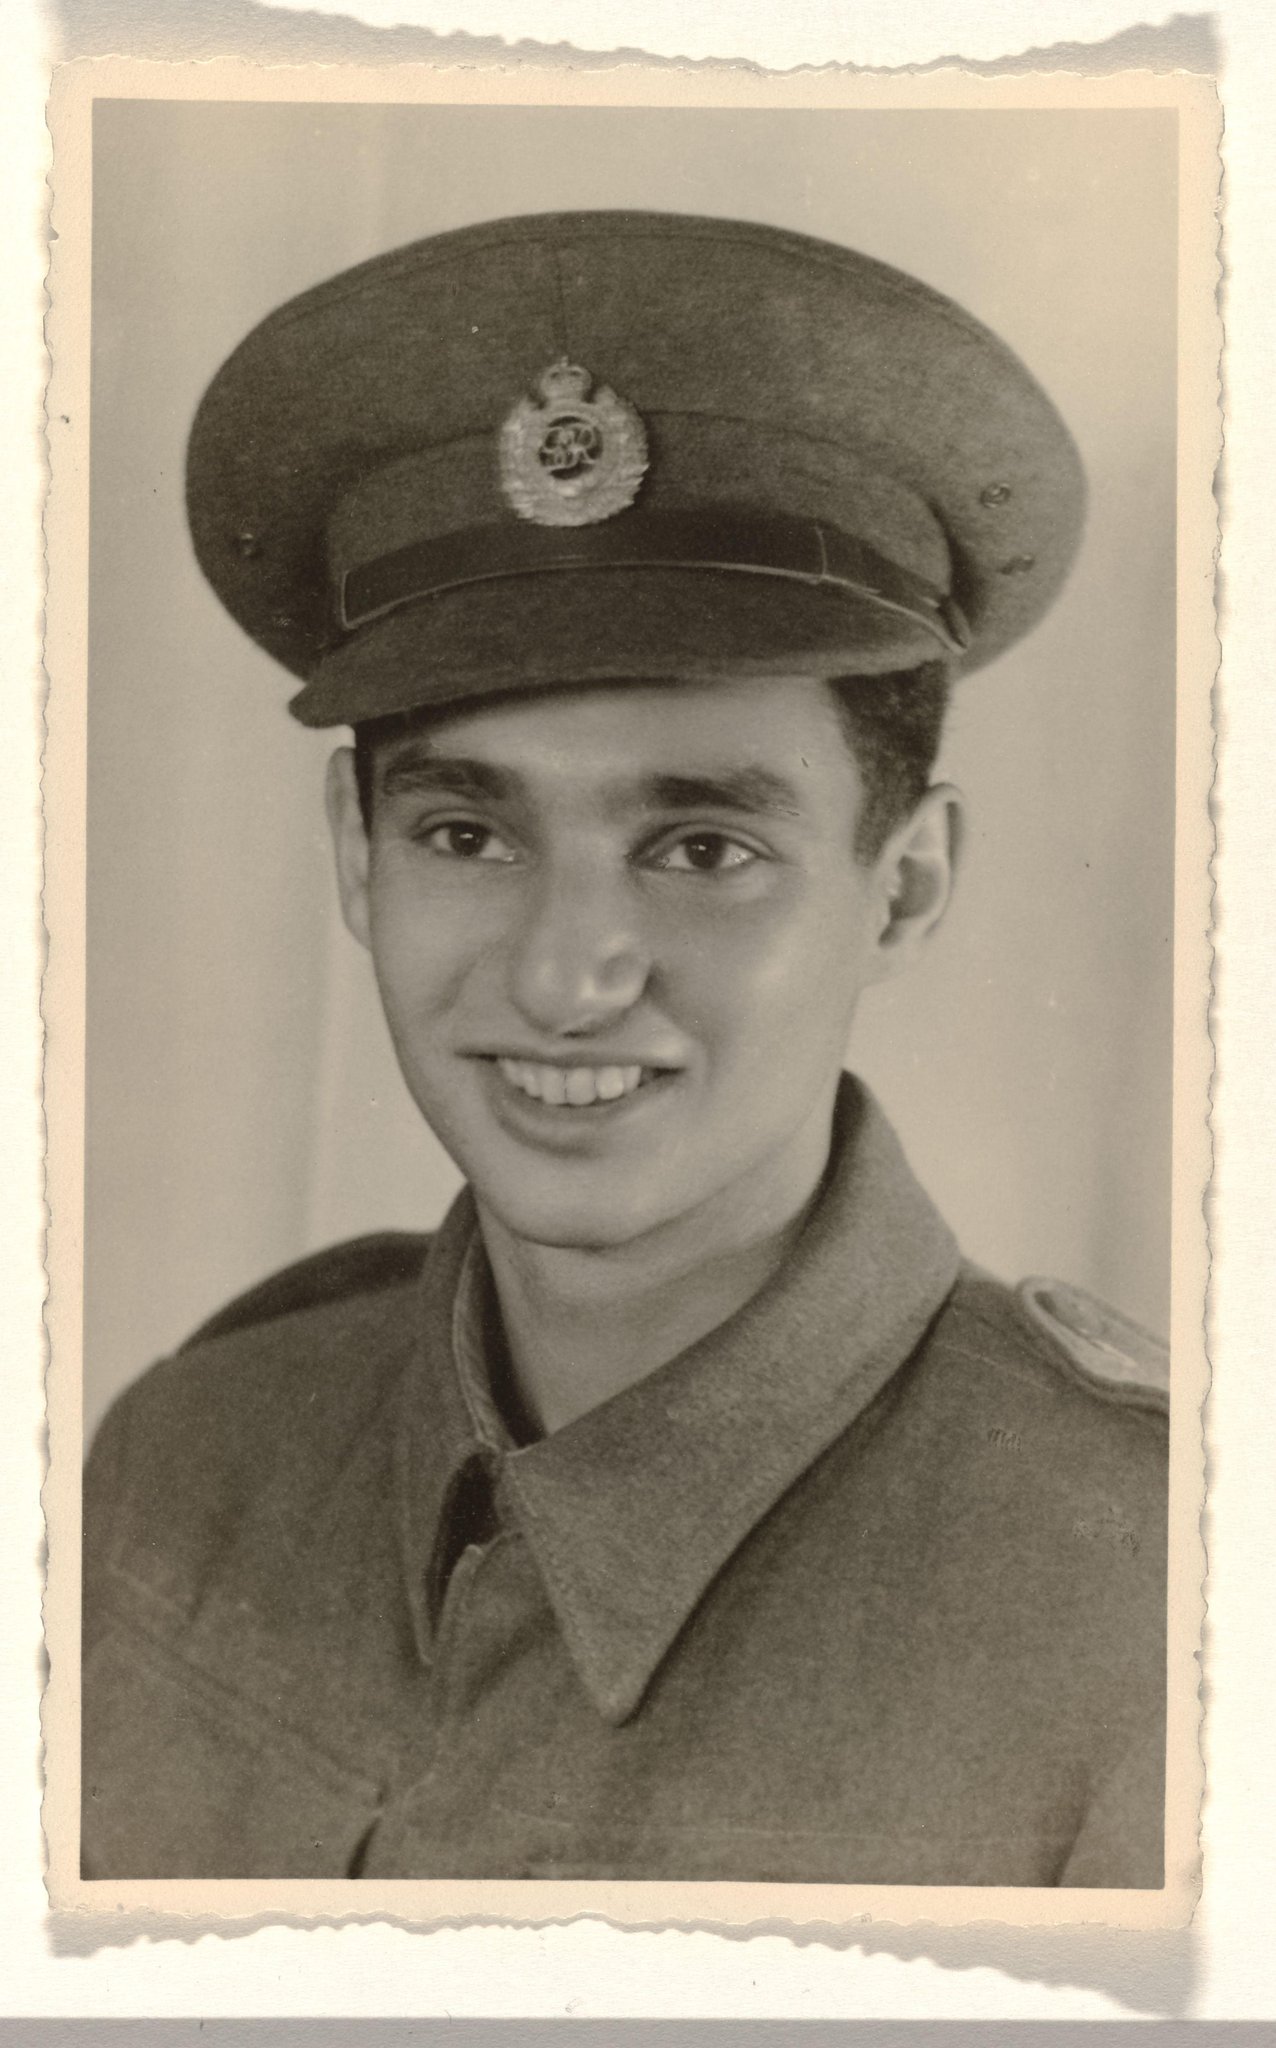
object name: photograph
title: Karl-Heinz Arndtheim, de tweede echtgenoot van Isabel Wachenheimer, in militair uniform met militair hoofddeksel op het hoofd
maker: Anonymous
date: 1944-1955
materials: photographic support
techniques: gelatin silver print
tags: karl-heinz arndtheim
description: Karl-Heinz Arndtheim, de tweede echtgenoot van Isabel Wachenheimer, in militair uniform met militair hoofddeksel op het hoofd.